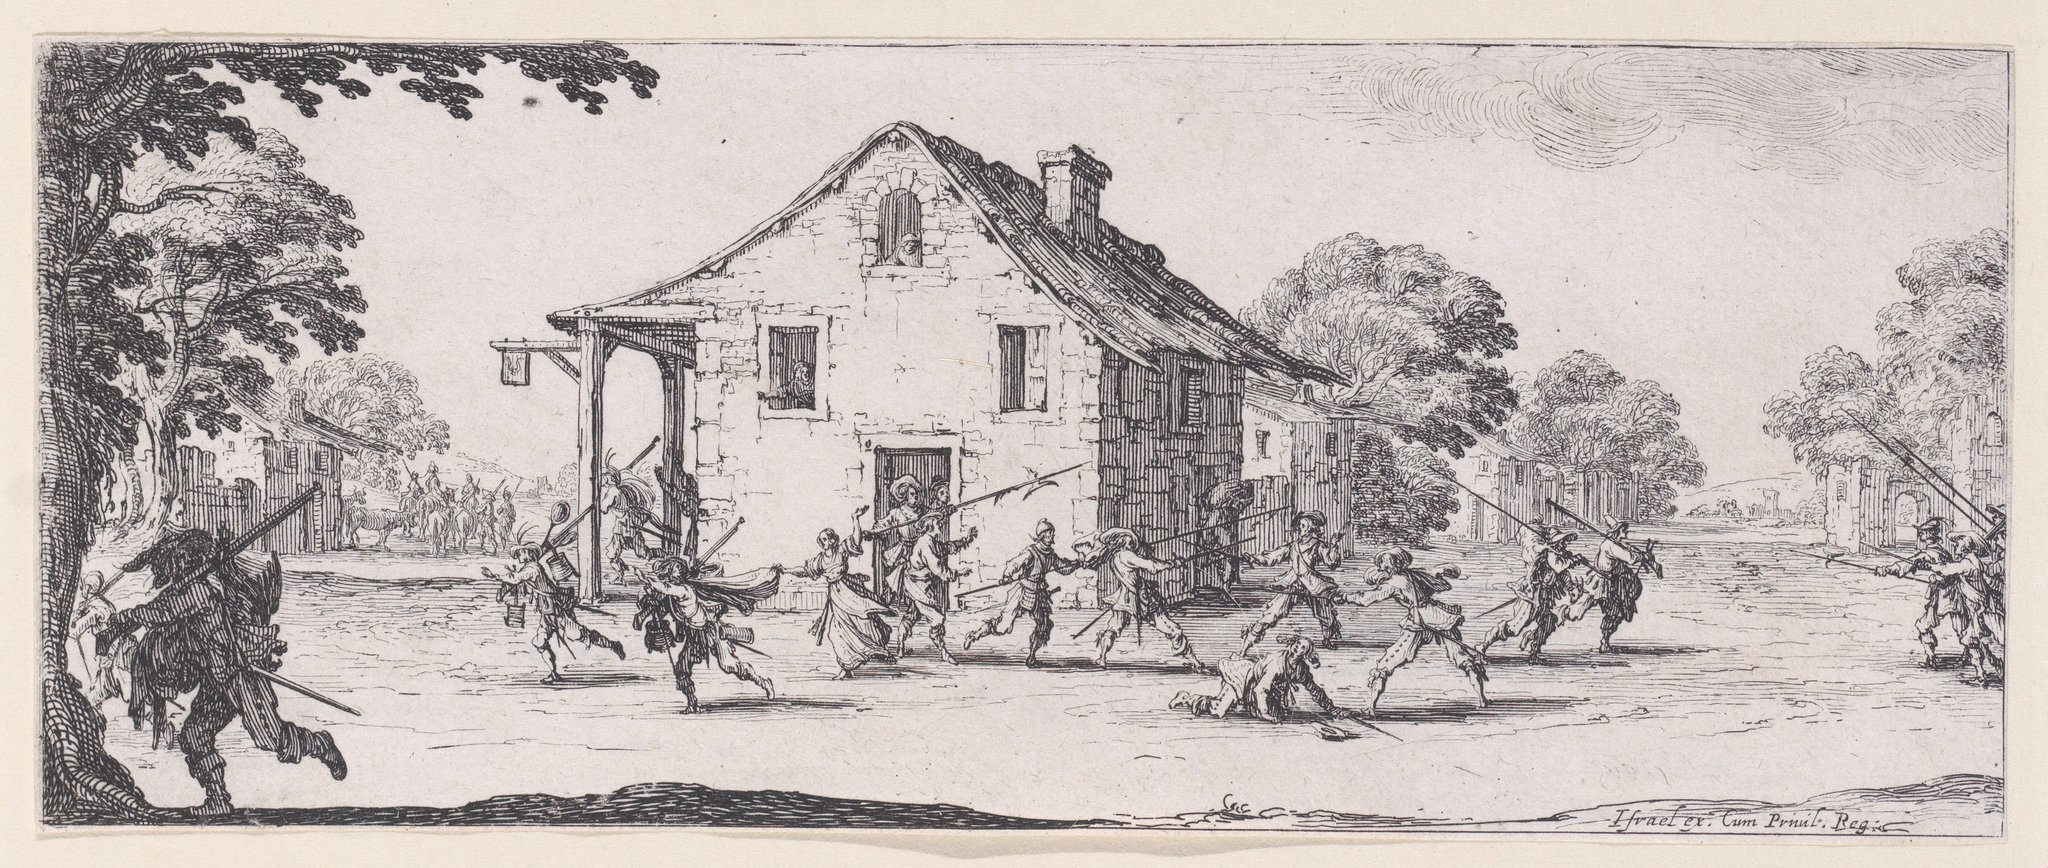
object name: print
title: La Maraude (Pilfering), plate 4 from "Les Misères et les Mal-Heures de la Guerre" (The Miseries and Misfortunes of War)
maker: jacques callot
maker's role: artist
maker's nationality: french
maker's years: 1592-1635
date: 1633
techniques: etching